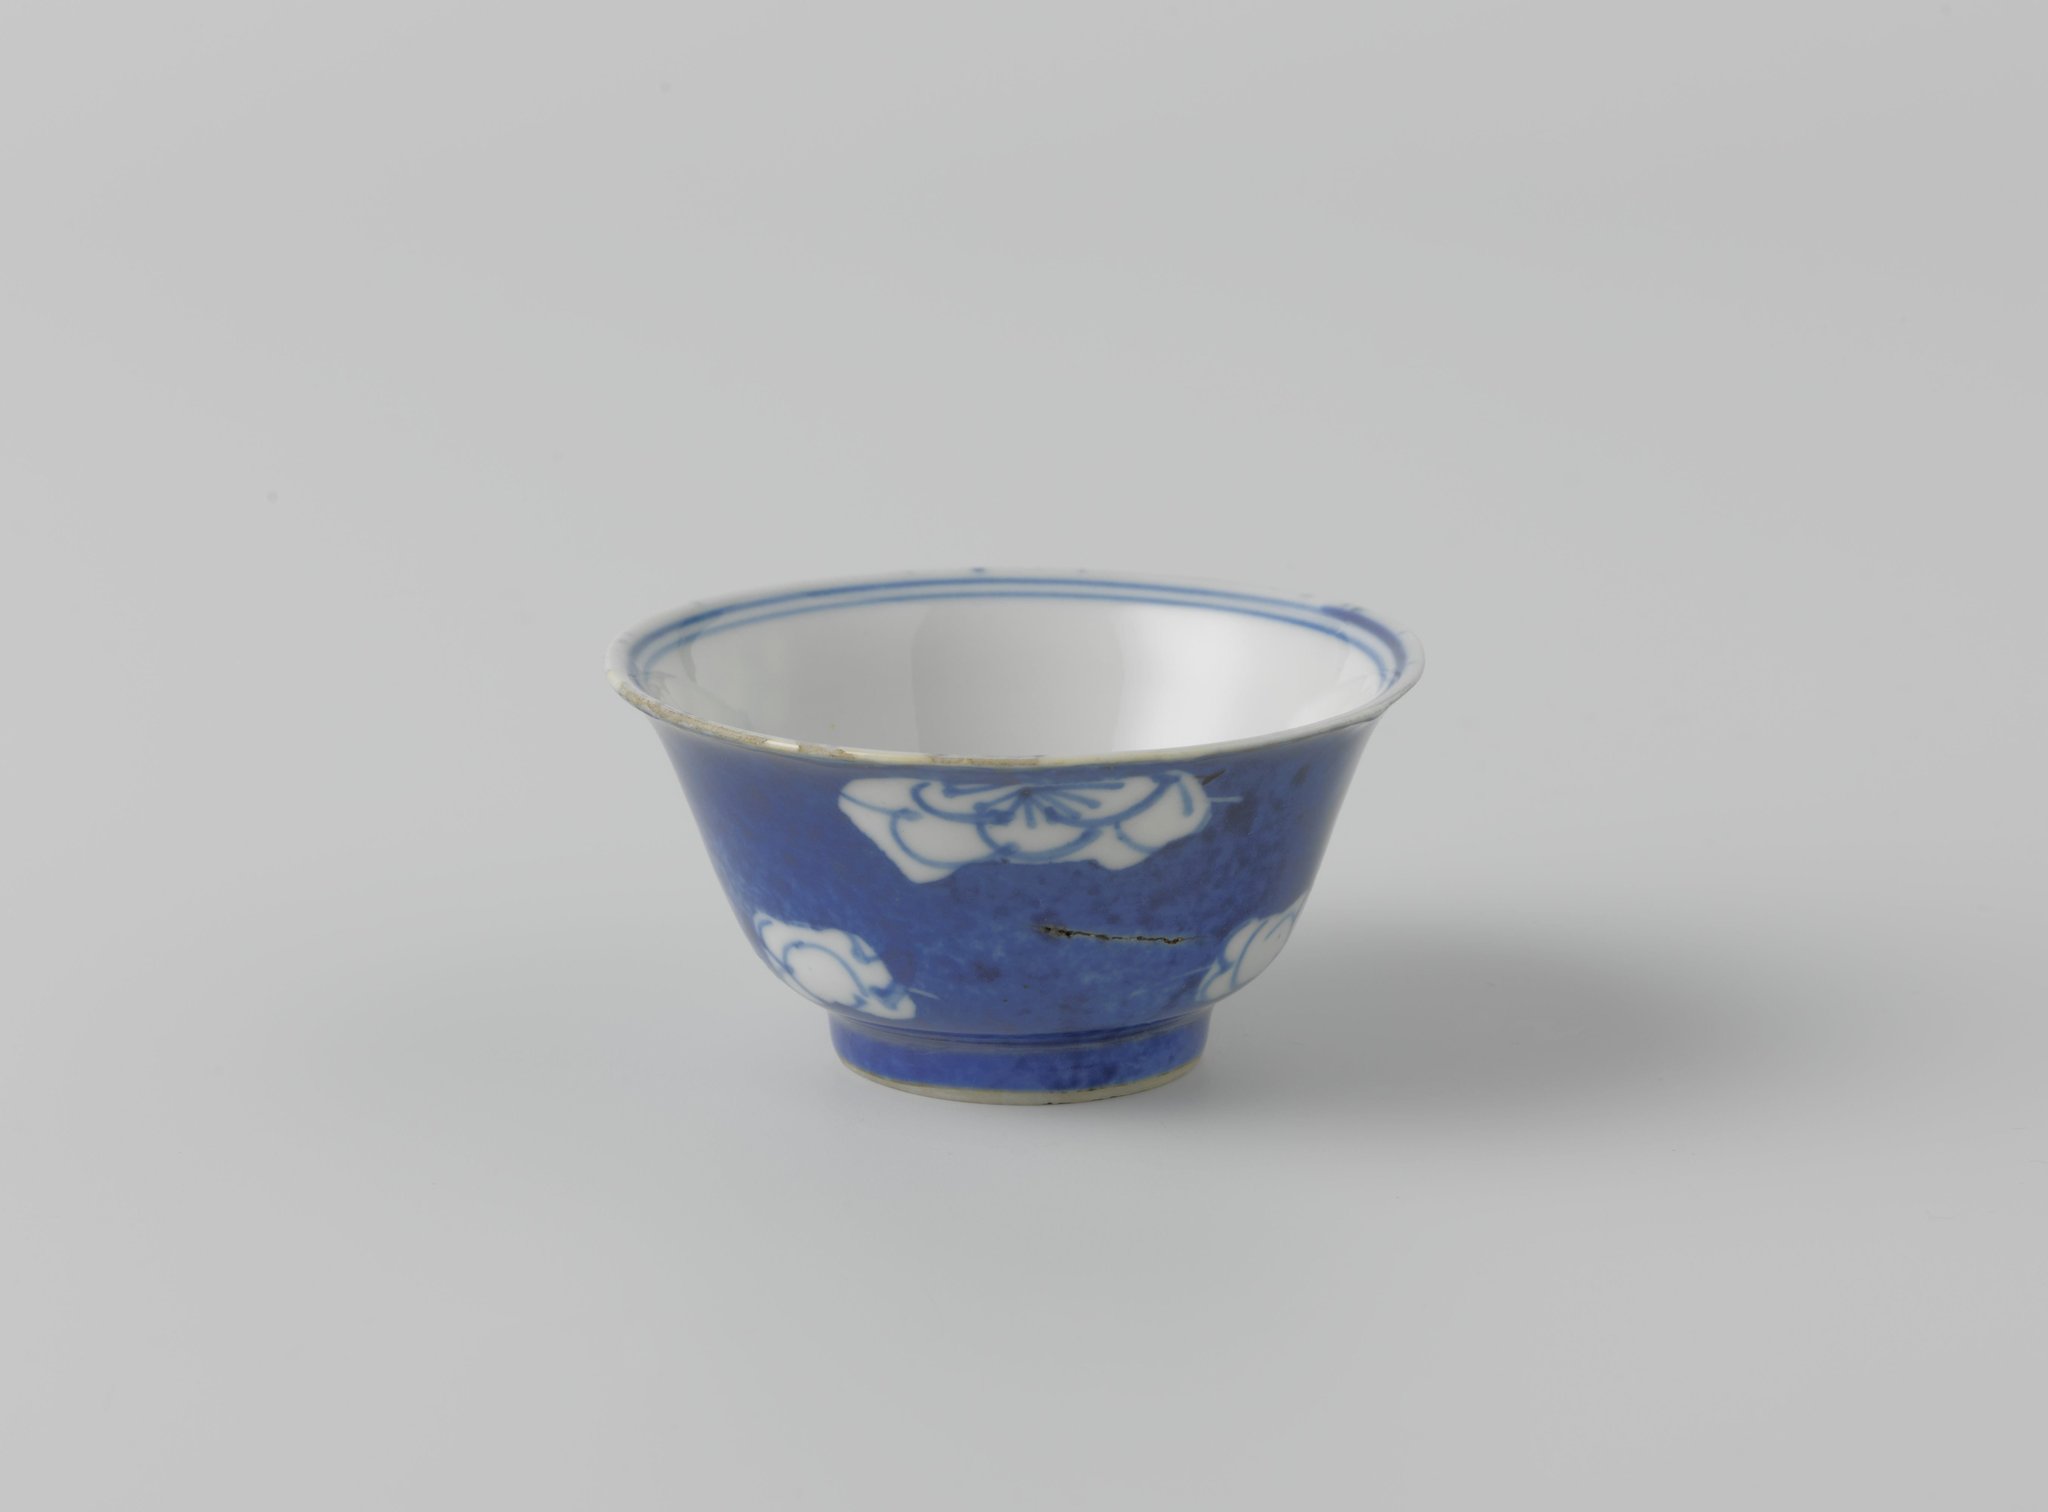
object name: cup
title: Bell-shaped cup with powder blue and flower heads in reserve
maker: Anonymous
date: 1700-1724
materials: cobalt, glaze, paint, porcelain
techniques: firing, turning, vitrification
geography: china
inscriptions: mark